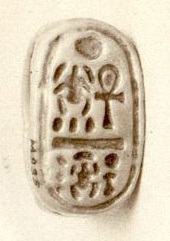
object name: ring, ankhkheperure feminine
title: Signet Ring, Ankhkheperure beloved (feminine) of Neferkheperure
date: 1353-1336 BCE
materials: faience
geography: egypt